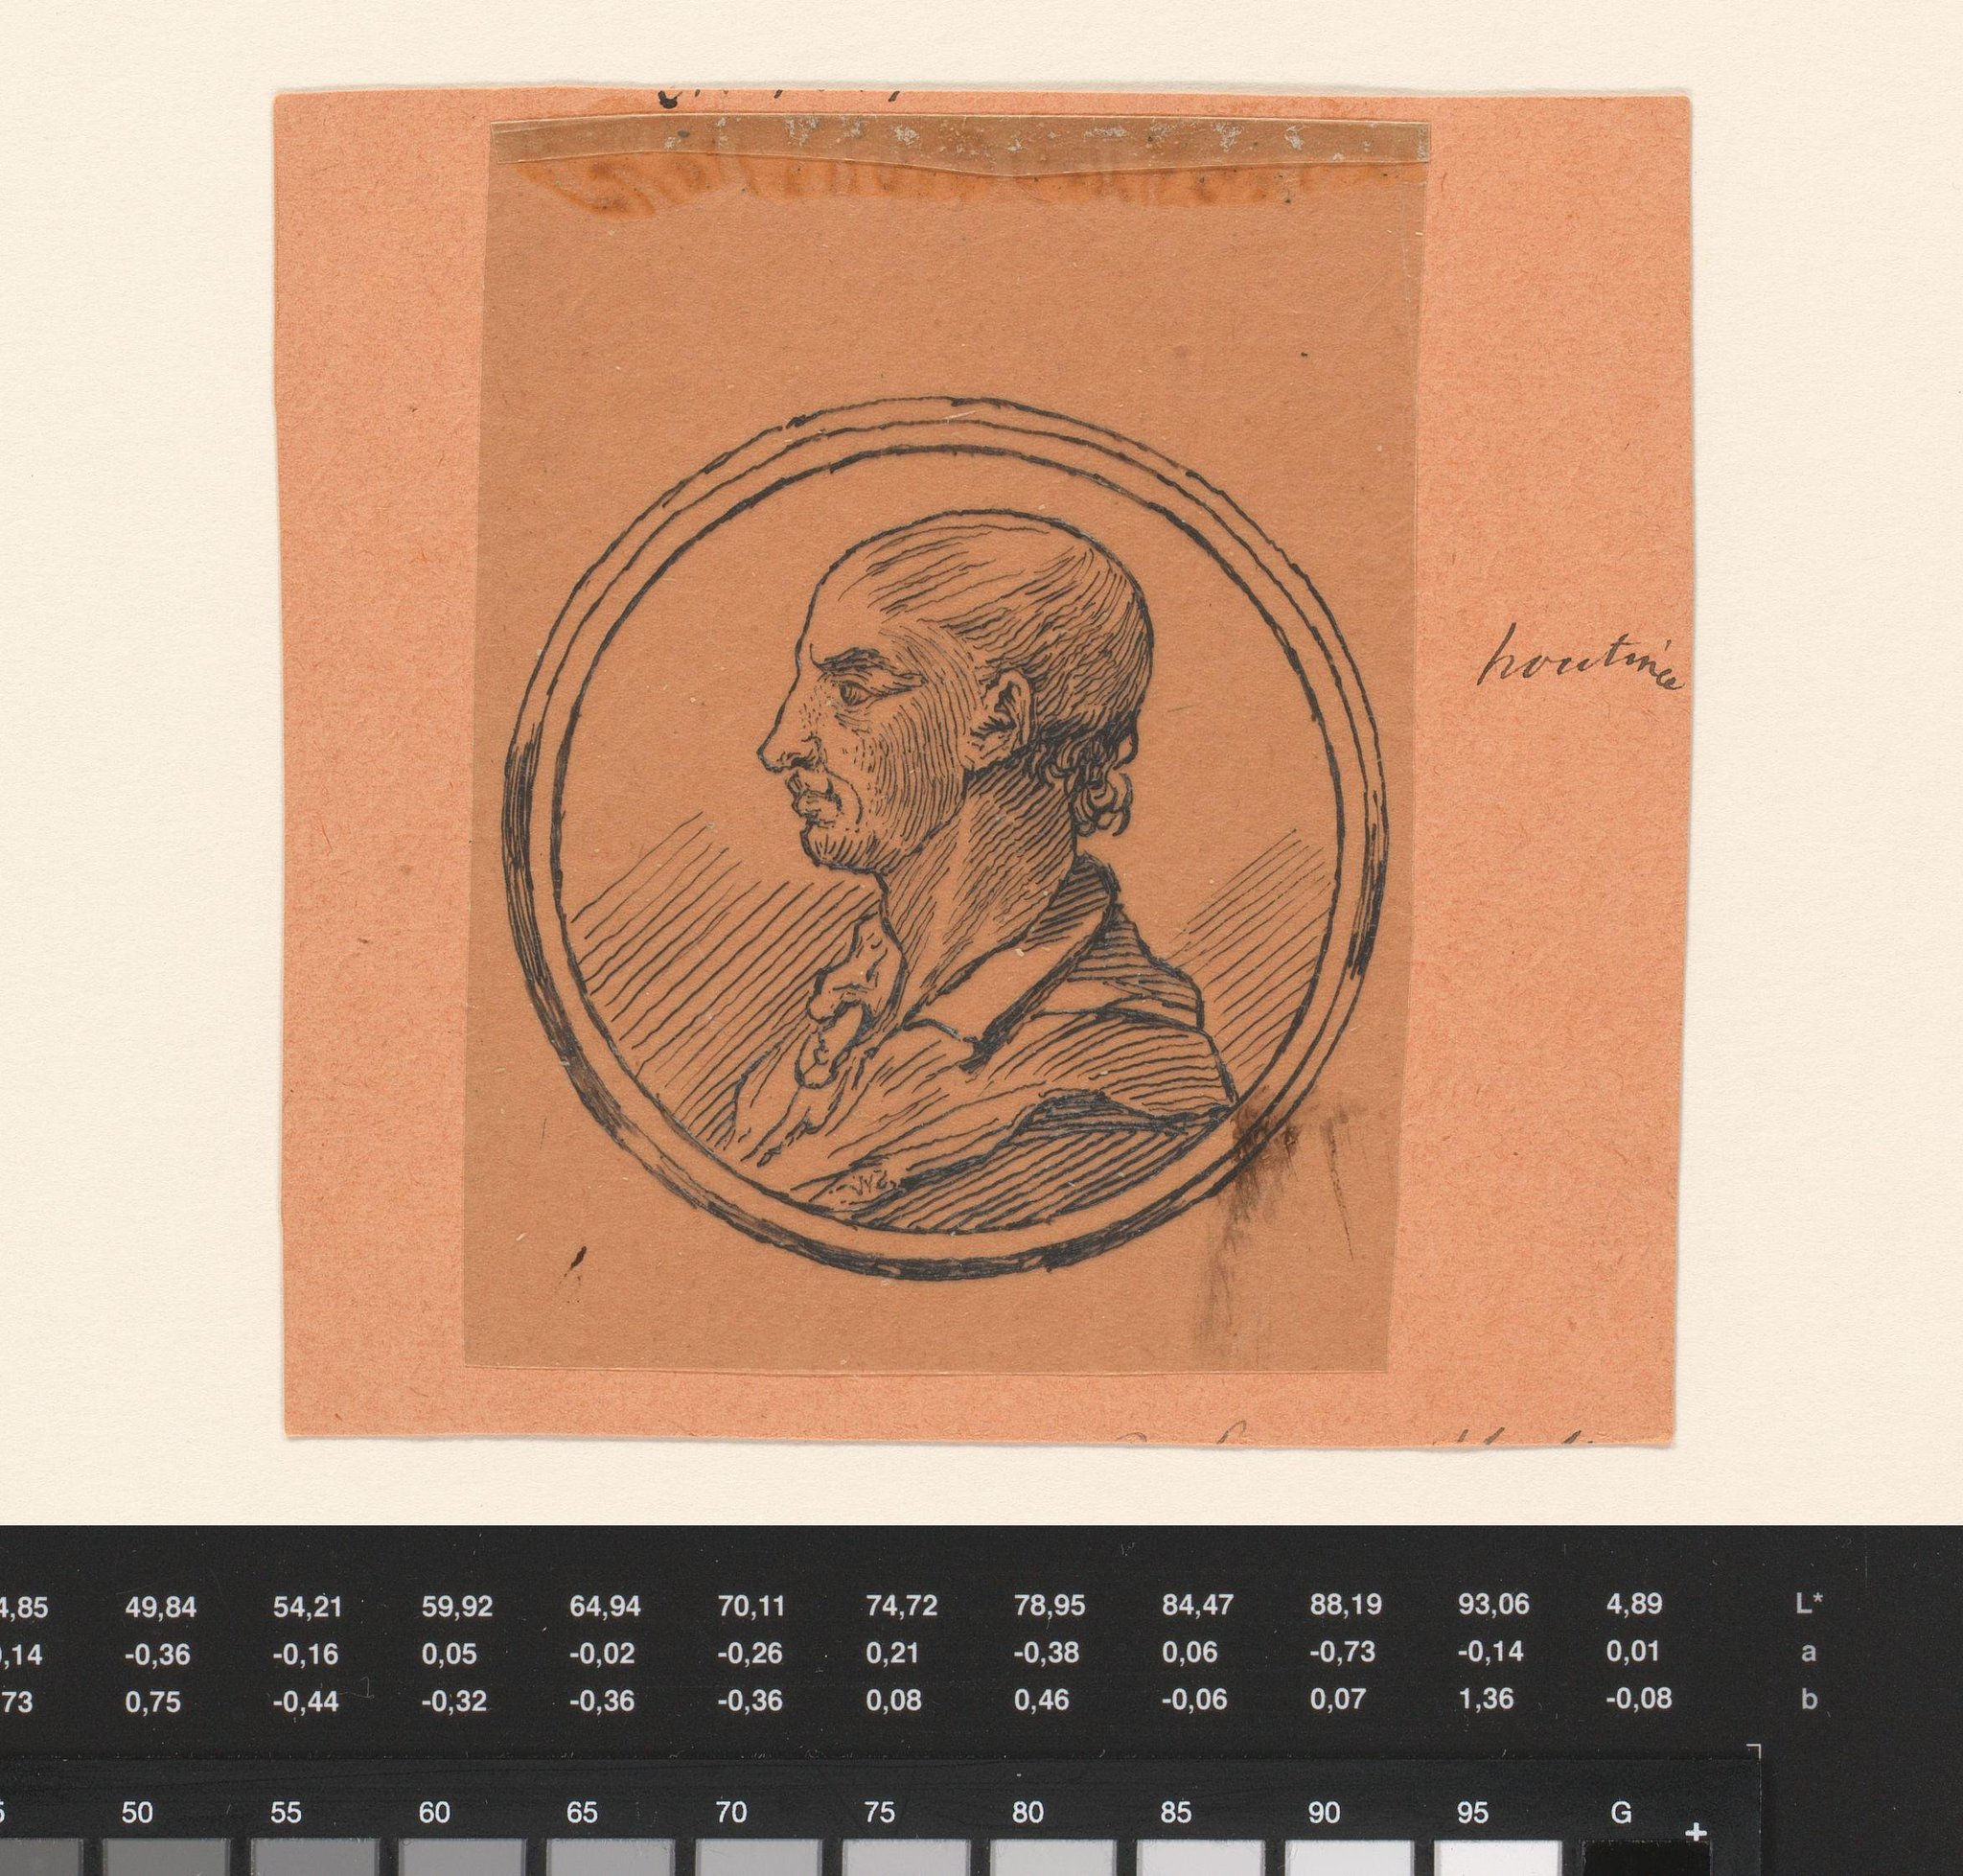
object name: drawing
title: Portret van een onbekende man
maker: Anonymous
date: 1850-1950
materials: ink, paper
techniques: pen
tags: historical persons not known by name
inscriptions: inscription: ‘houtince (?)’